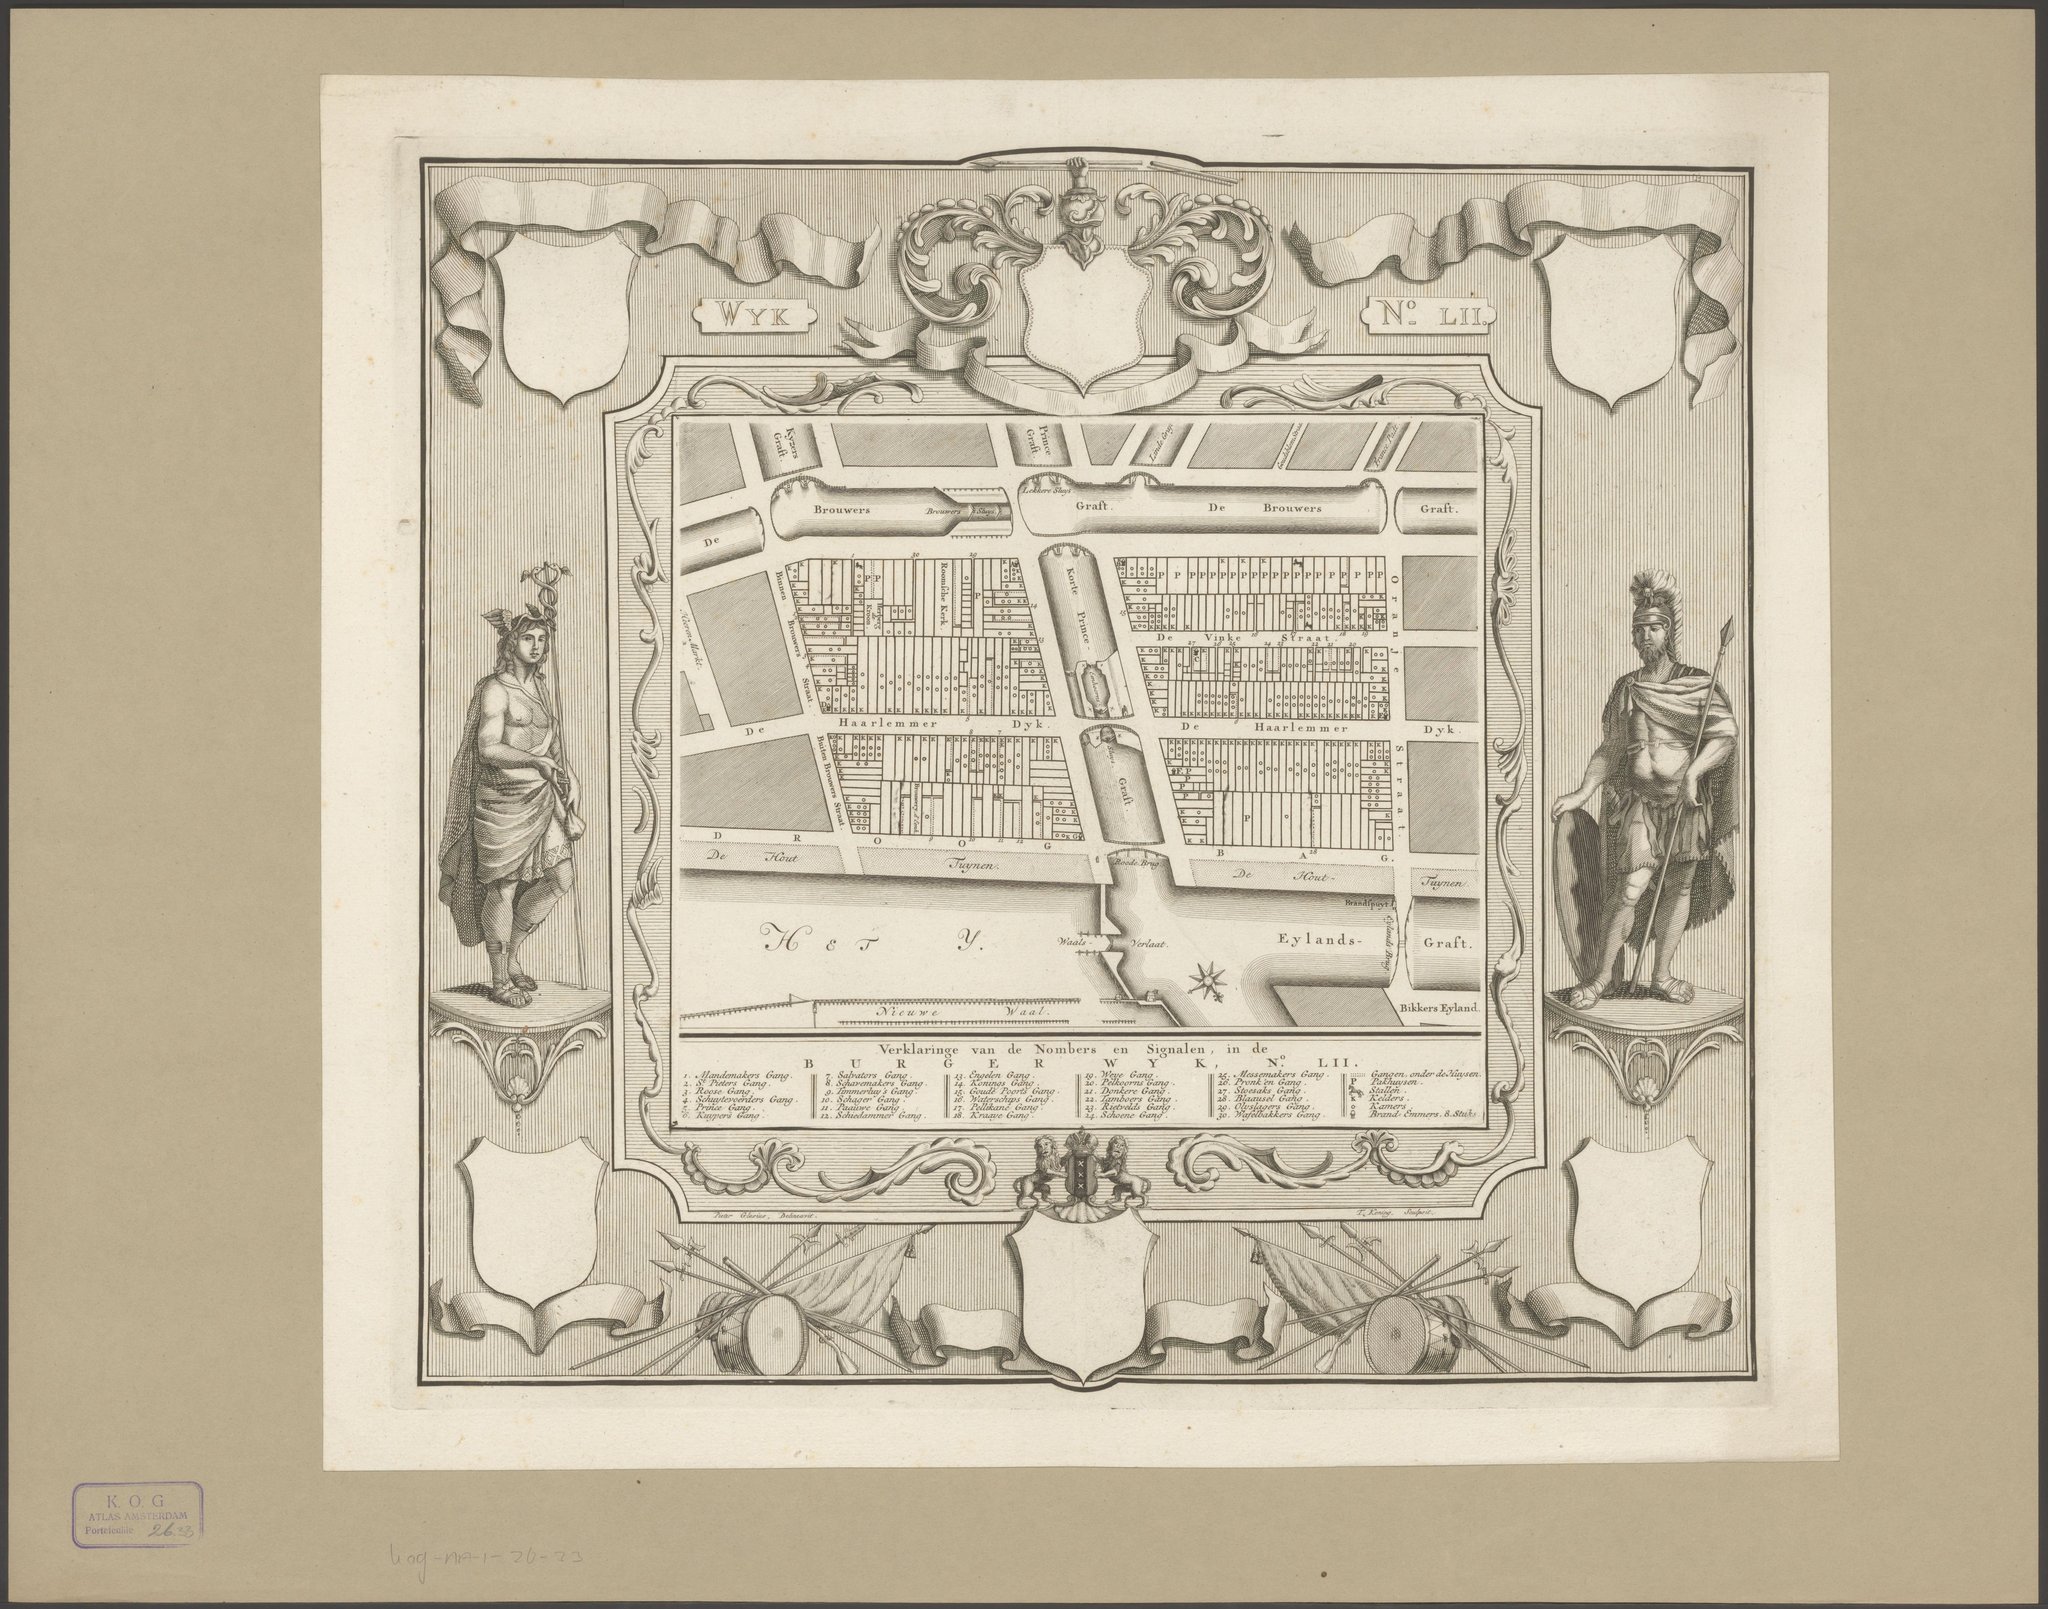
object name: print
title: Plattegrond van burgerwijk LII te Amsterdam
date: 1765-1772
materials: paper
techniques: engraving, etching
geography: amsterdam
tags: coat of arms (as symbol of the state, etc.) (+ city; municipal), (story of) mars (ares), (story of) mercury (hermes), maps of cities, amsterdam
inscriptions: collector's mark: Lugt 1641b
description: De lege wapenschilden en banderollen werden met knipsels ingevuld, met bovenaan, van links naar rechts, de wapens van luitenant Iperus Wiselius, kapitein Willem van der Meulen en vaandrig Jan Wiselius, en onderaan, van links naar rechts, de wapens van sergeanten Leendert Reyne, Benjamin Groen en Hendrik Spokebrand. Zij waren tussen 1765 en 1772 in deze combinatie in functie.